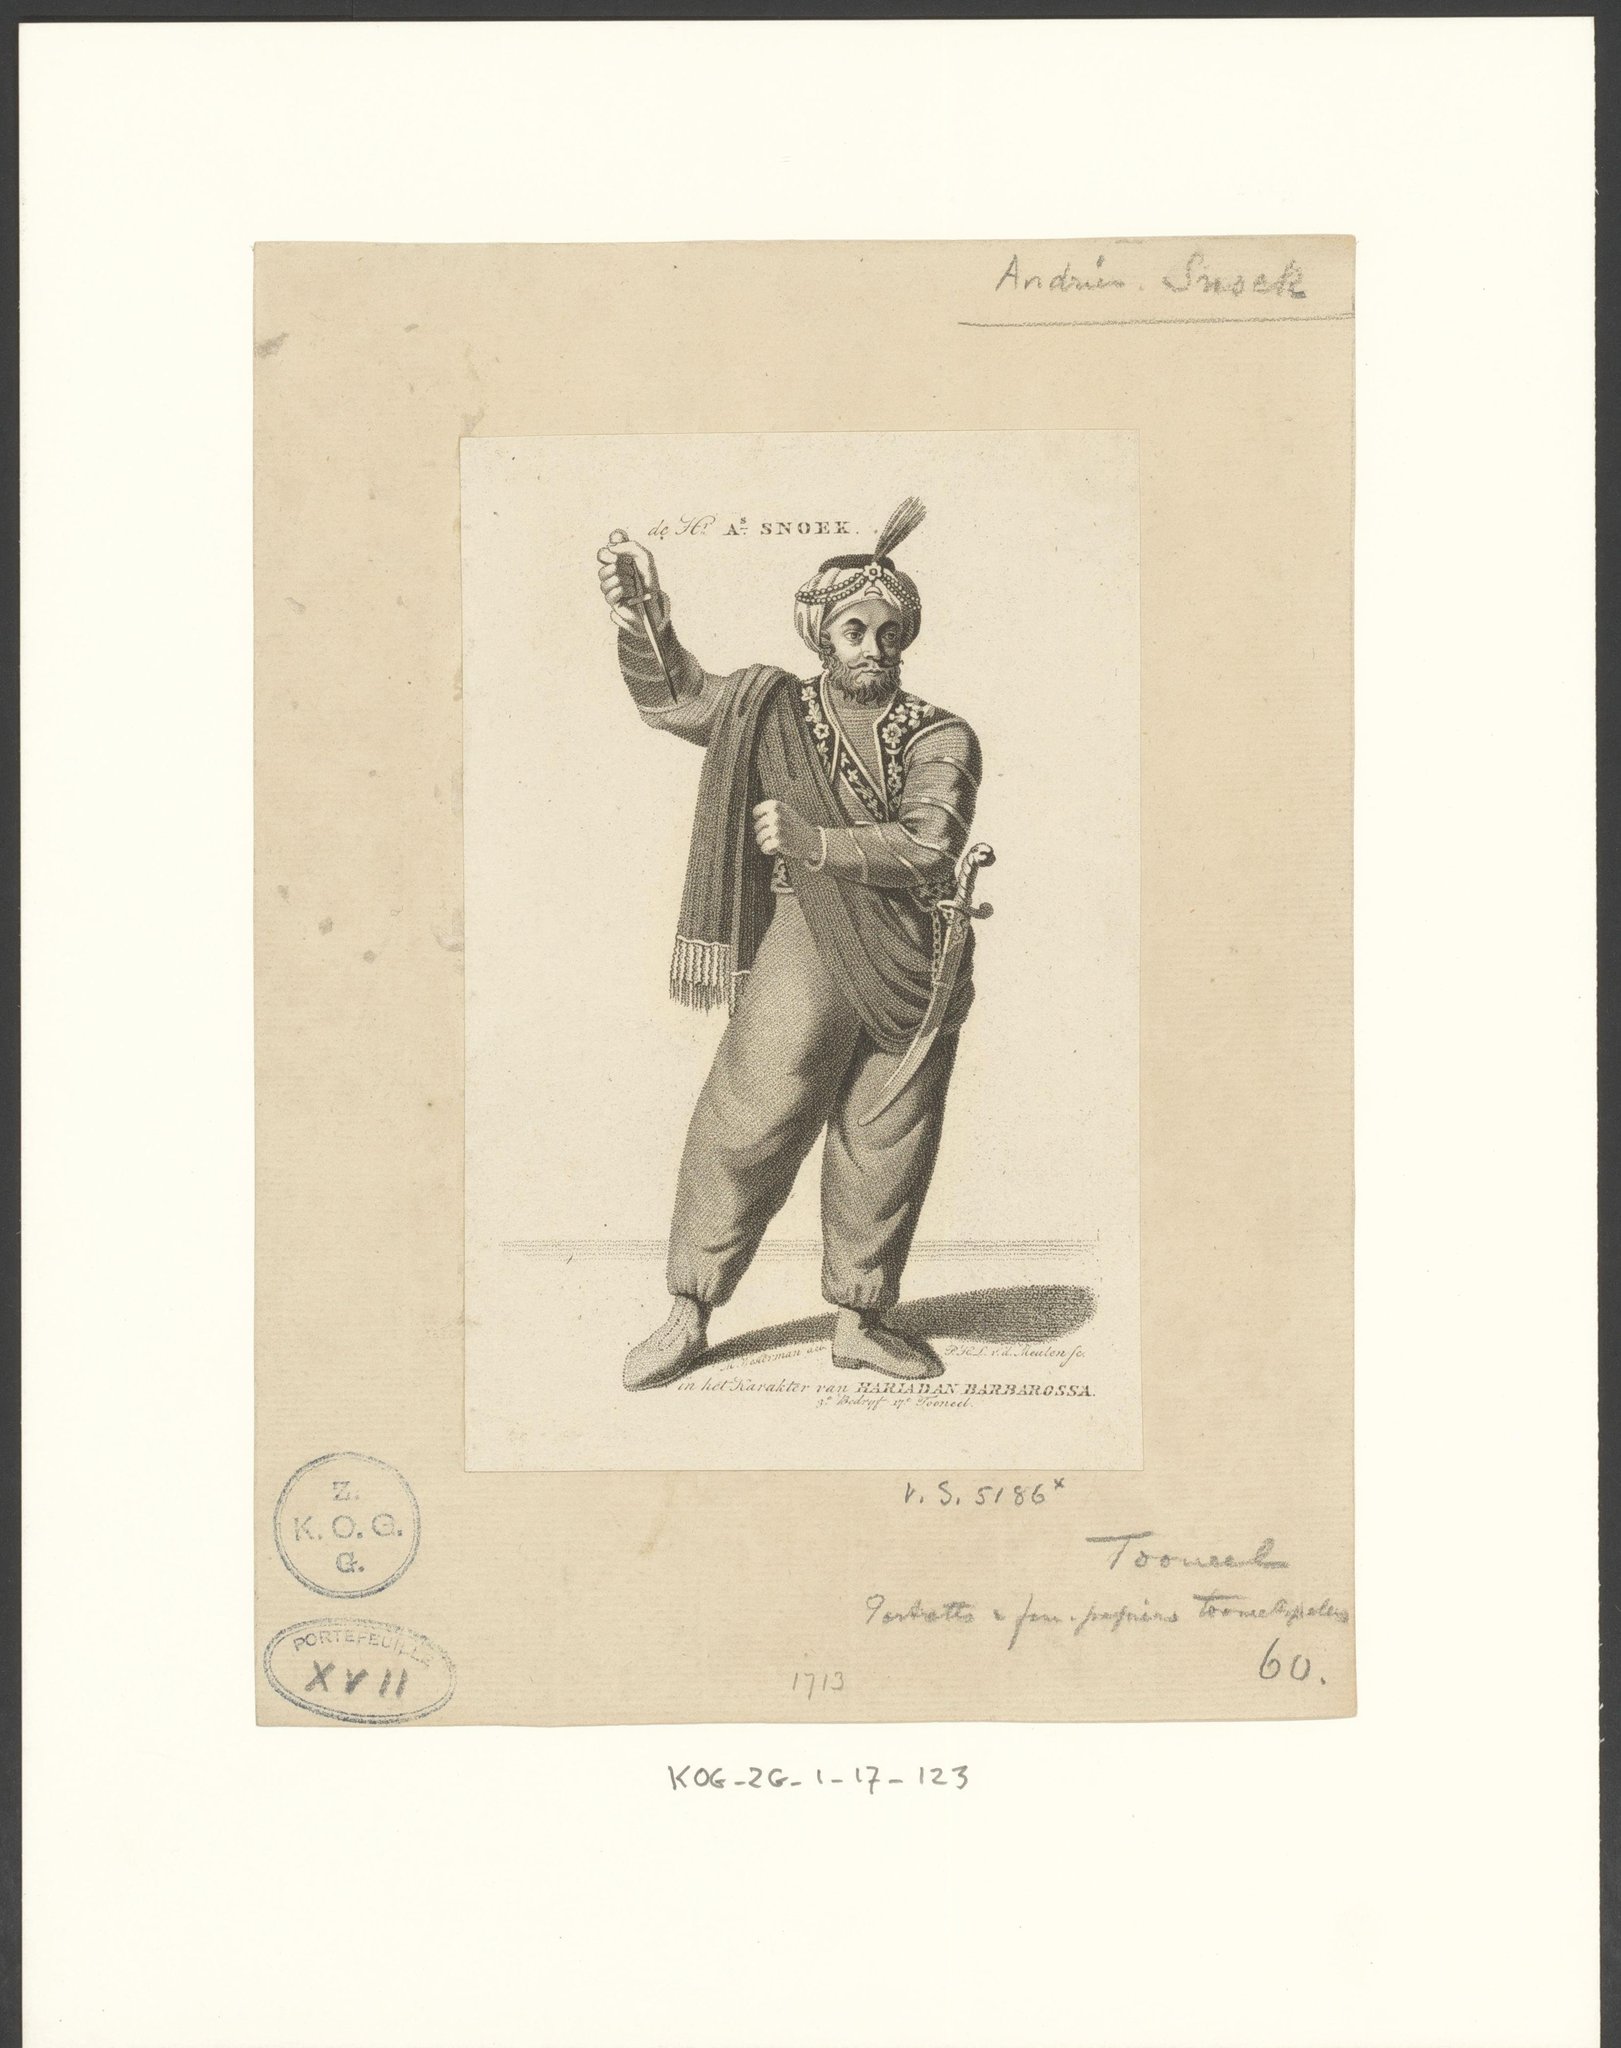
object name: print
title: Portret van Andreas Snoek als Hariadan Barbarossa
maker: pieter van der meulen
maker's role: draughtsman, painter, print maker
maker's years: 1780-1858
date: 1805-1836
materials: paper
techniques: etching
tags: the hague, actor (on the stage)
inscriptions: stamp, collector's mark: Lugt 1641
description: Portret ten voeten uit van Andreas Snoek in de rol van Hariadan Barbarossa. Onderwerpsrubrieken binnen de Atlas Zeden en Gewoonten: Tooneel, Portretten van toneelspelers.